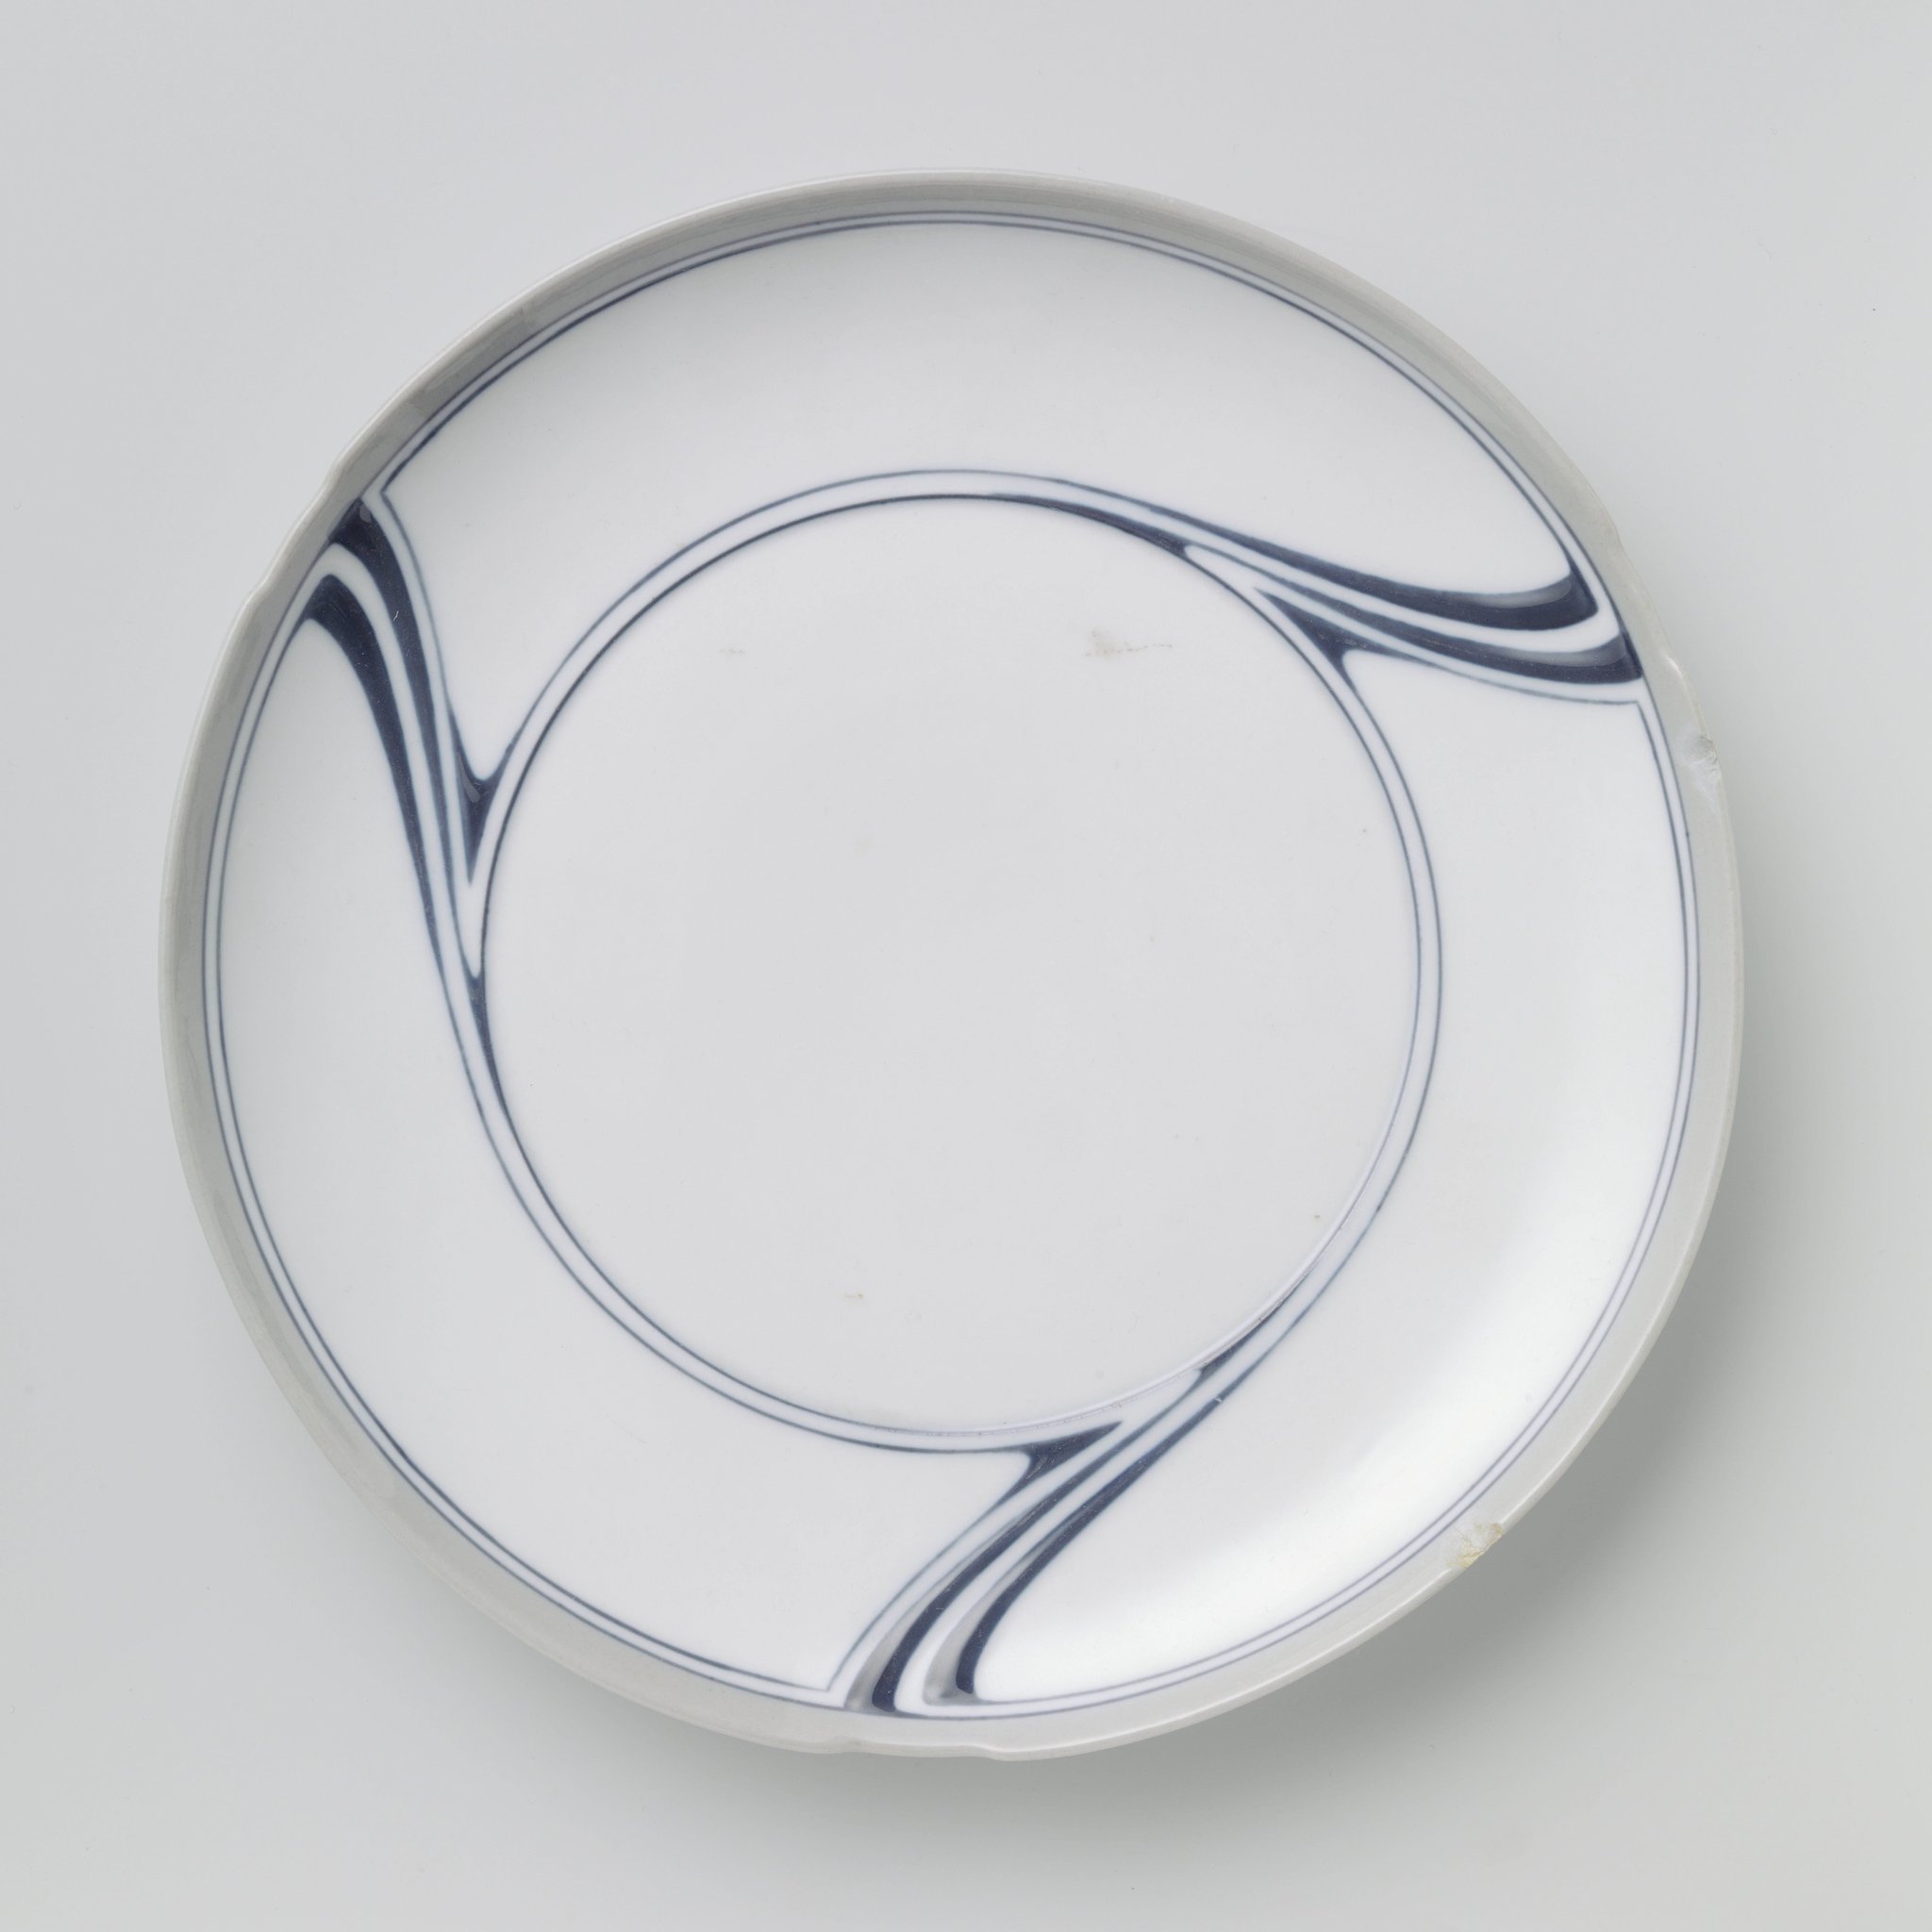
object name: eating drinking utensil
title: Bord uit het koffie- en theeservies 'Saxonia'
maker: otto eduard voigt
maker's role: keramiekontwerper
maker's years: 1870-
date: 1904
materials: porcelain, chemical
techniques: painted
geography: meissen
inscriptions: mark: ‘22 (of 69?)’, factory mark, model number: ‘U 151’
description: Bord van porselein, beschilderd in blauw en grijs. Het bord hoort bij het koffie- en theeservies Saxonia. Het bord is gemerkt.